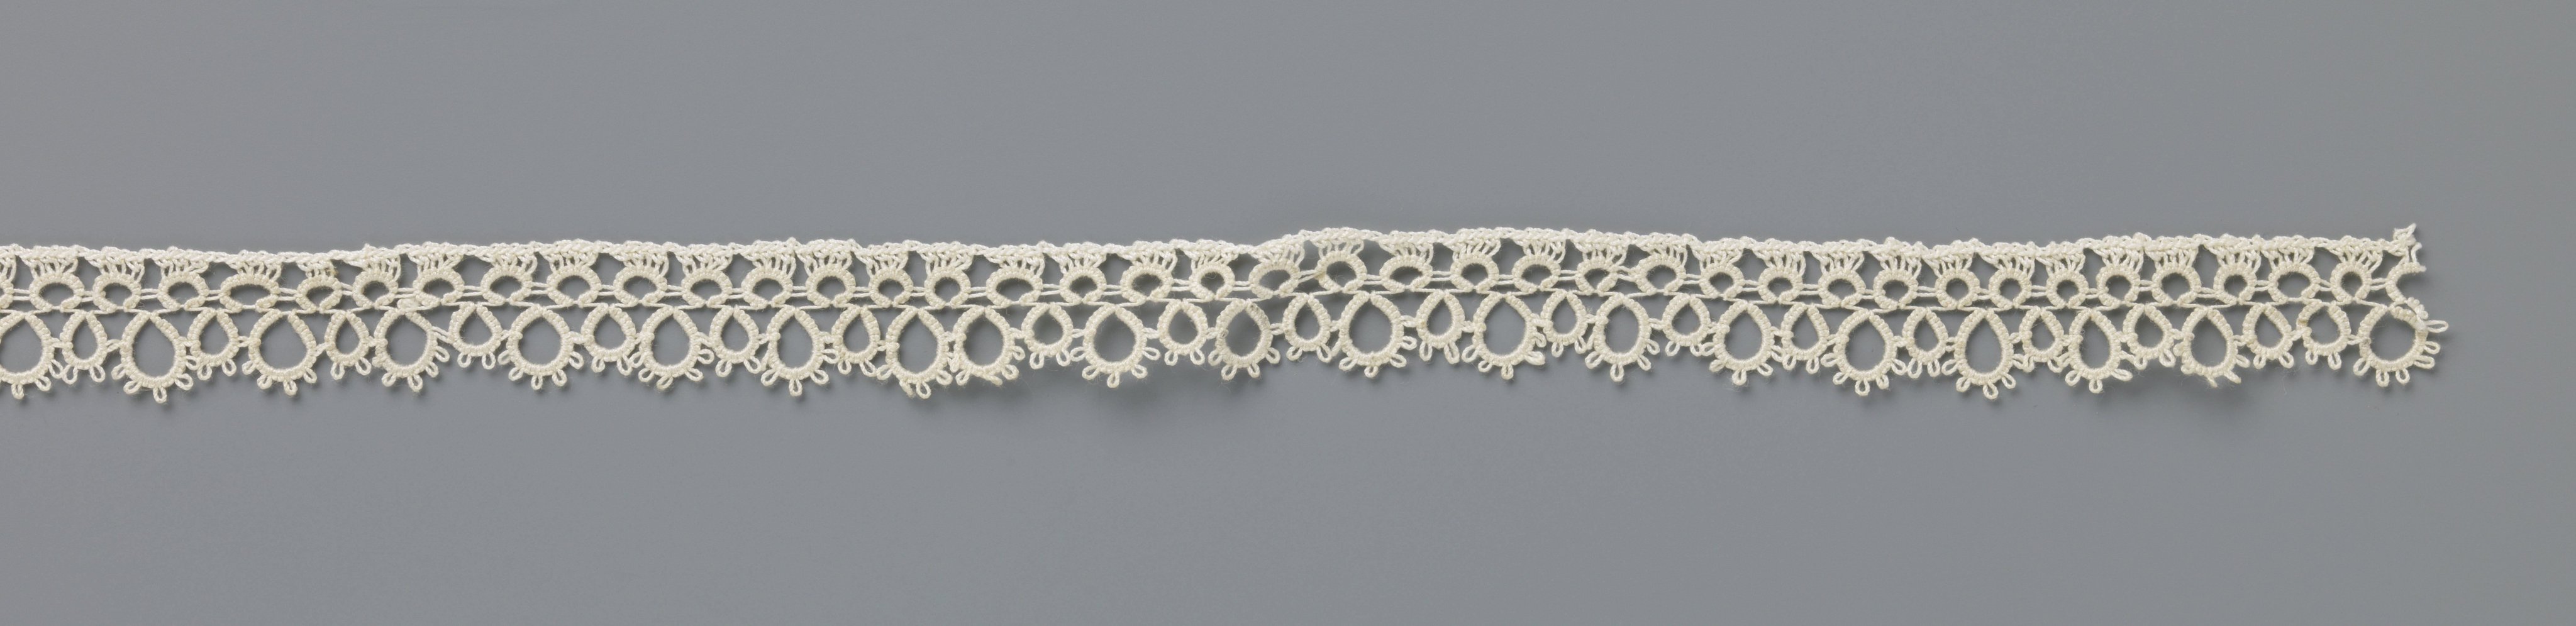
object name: strip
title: Strook geknoopte kant met twee rijen lussen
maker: marie waldeck-reiss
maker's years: 1870-1942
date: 1900-1939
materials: linen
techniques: tatting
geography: amsterdam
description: Strook naturelkleurige geknoopte kant: frivolité. Twee rijen lussen. De bovenste rij bestaat uit ovale lussen. De onderste rij heeft grotere druppelvormige lussen, afwisselend groter en kleiner. De bovenzijde is recht afgewerkt. De lussen zijn aan de onderzijde van de strook afgewerkt met picots.